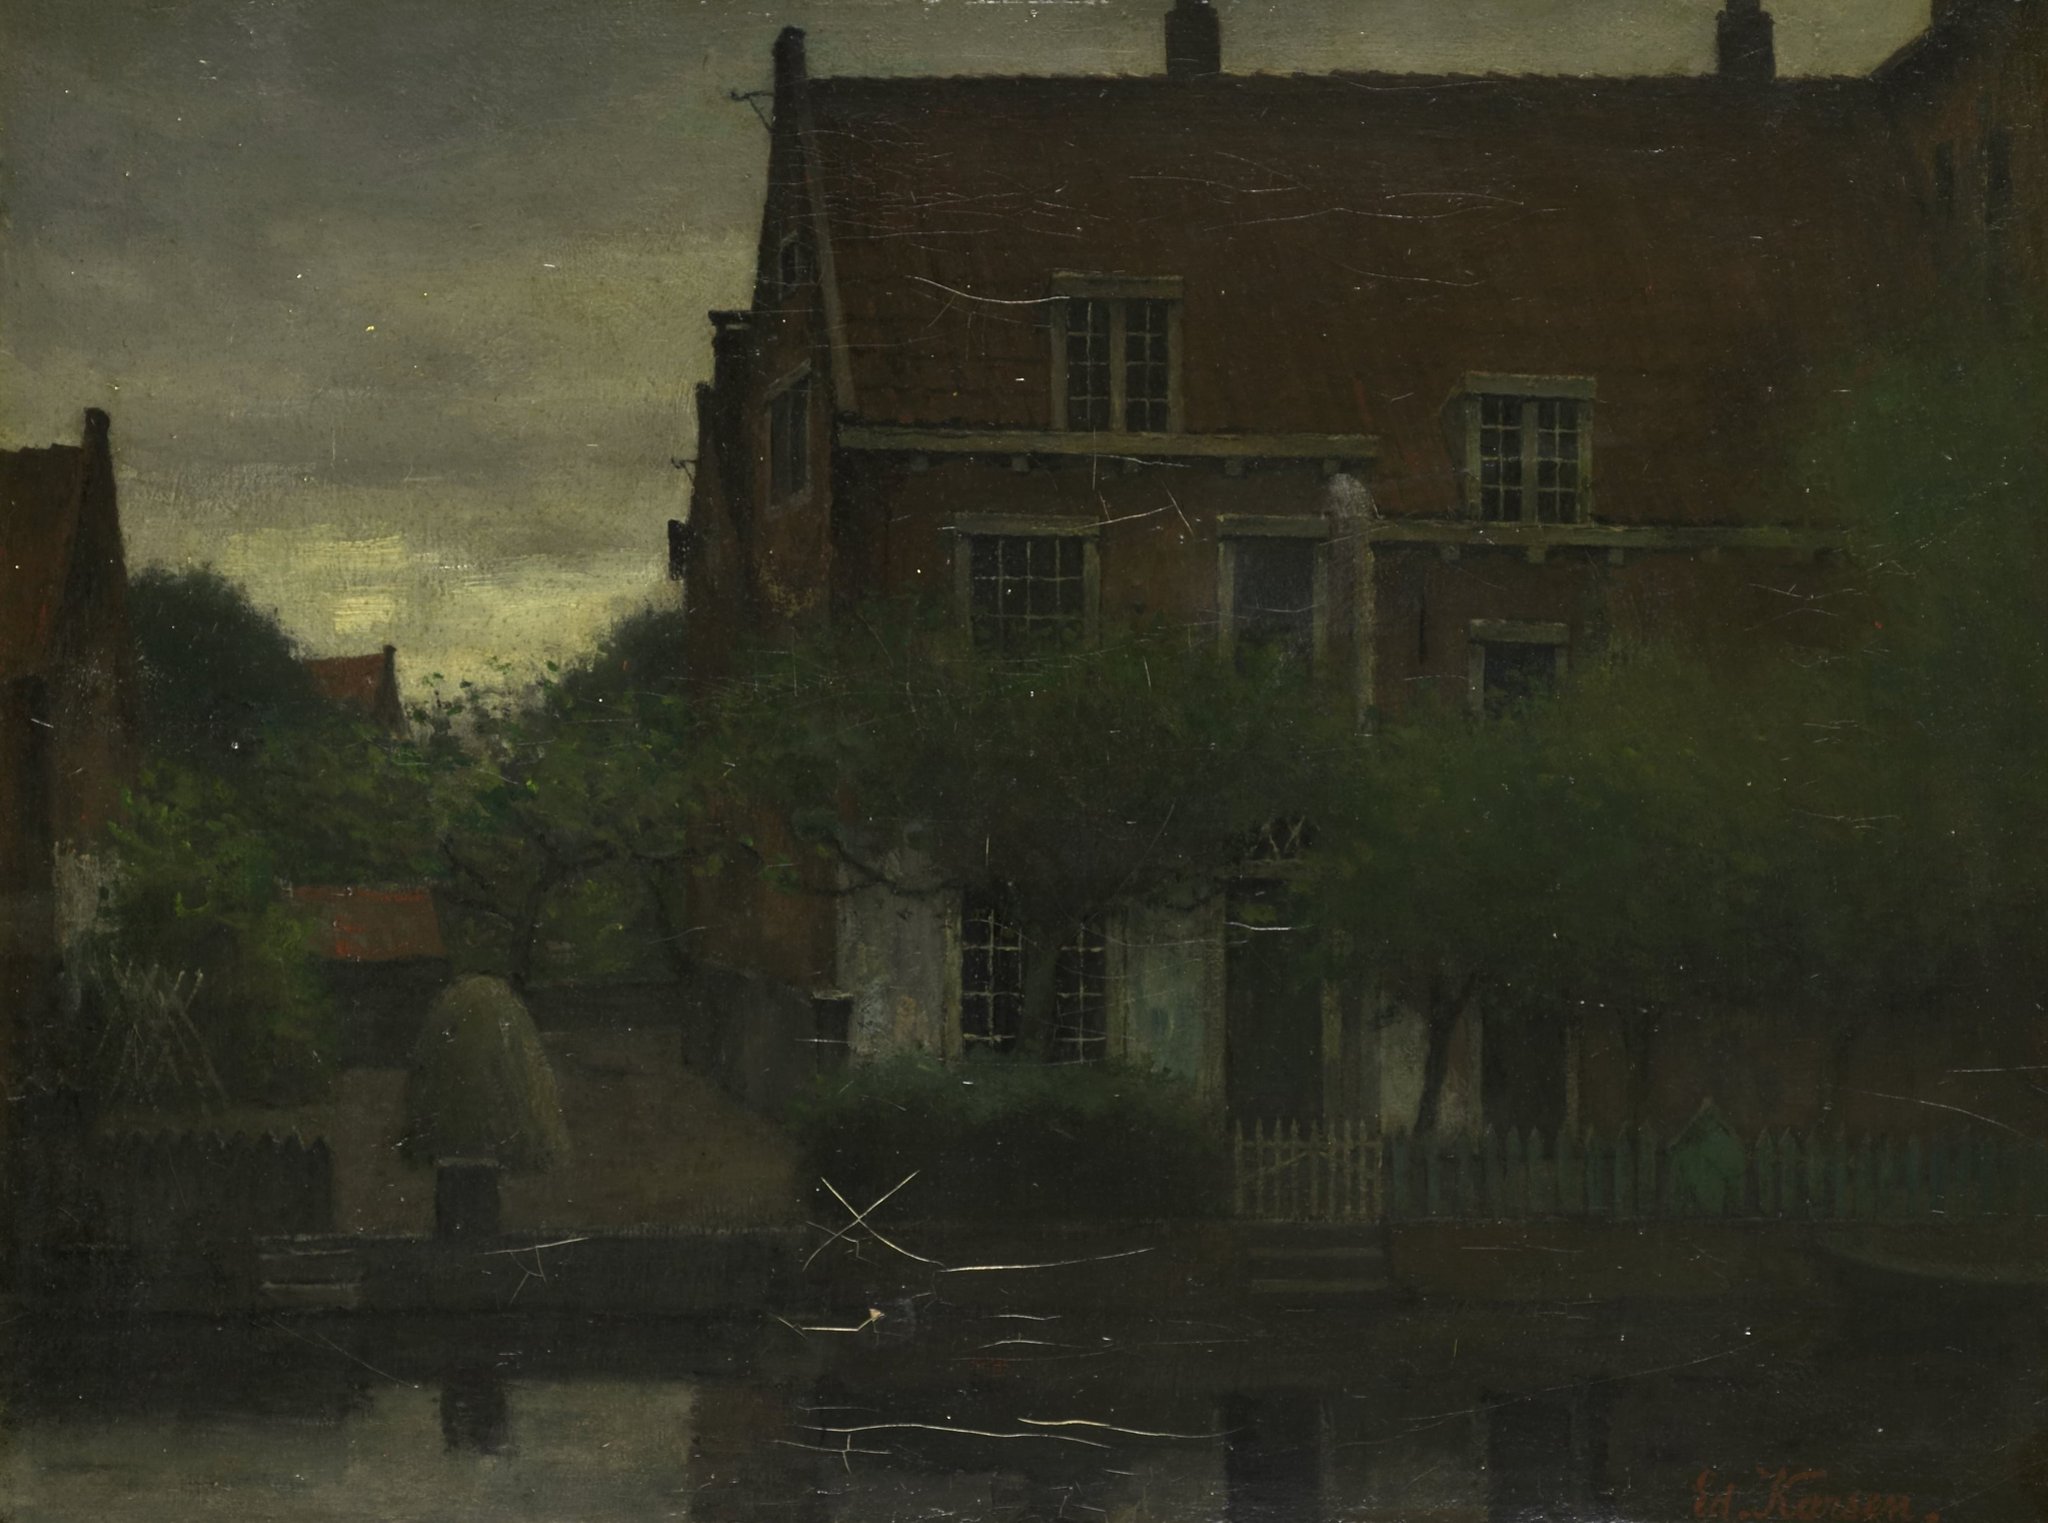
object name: painting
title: Overcast Day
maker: eduard karsen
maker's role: draughtsman, painter, print maker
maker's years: 1860-1941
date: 1885-1900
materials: canvas, oil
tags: public road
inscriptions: signature: ‘Ed. Karsen.’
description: Grijze dag. Gezicht op huizen gelegen achter een bomenrij en houten hek aan een vaart.